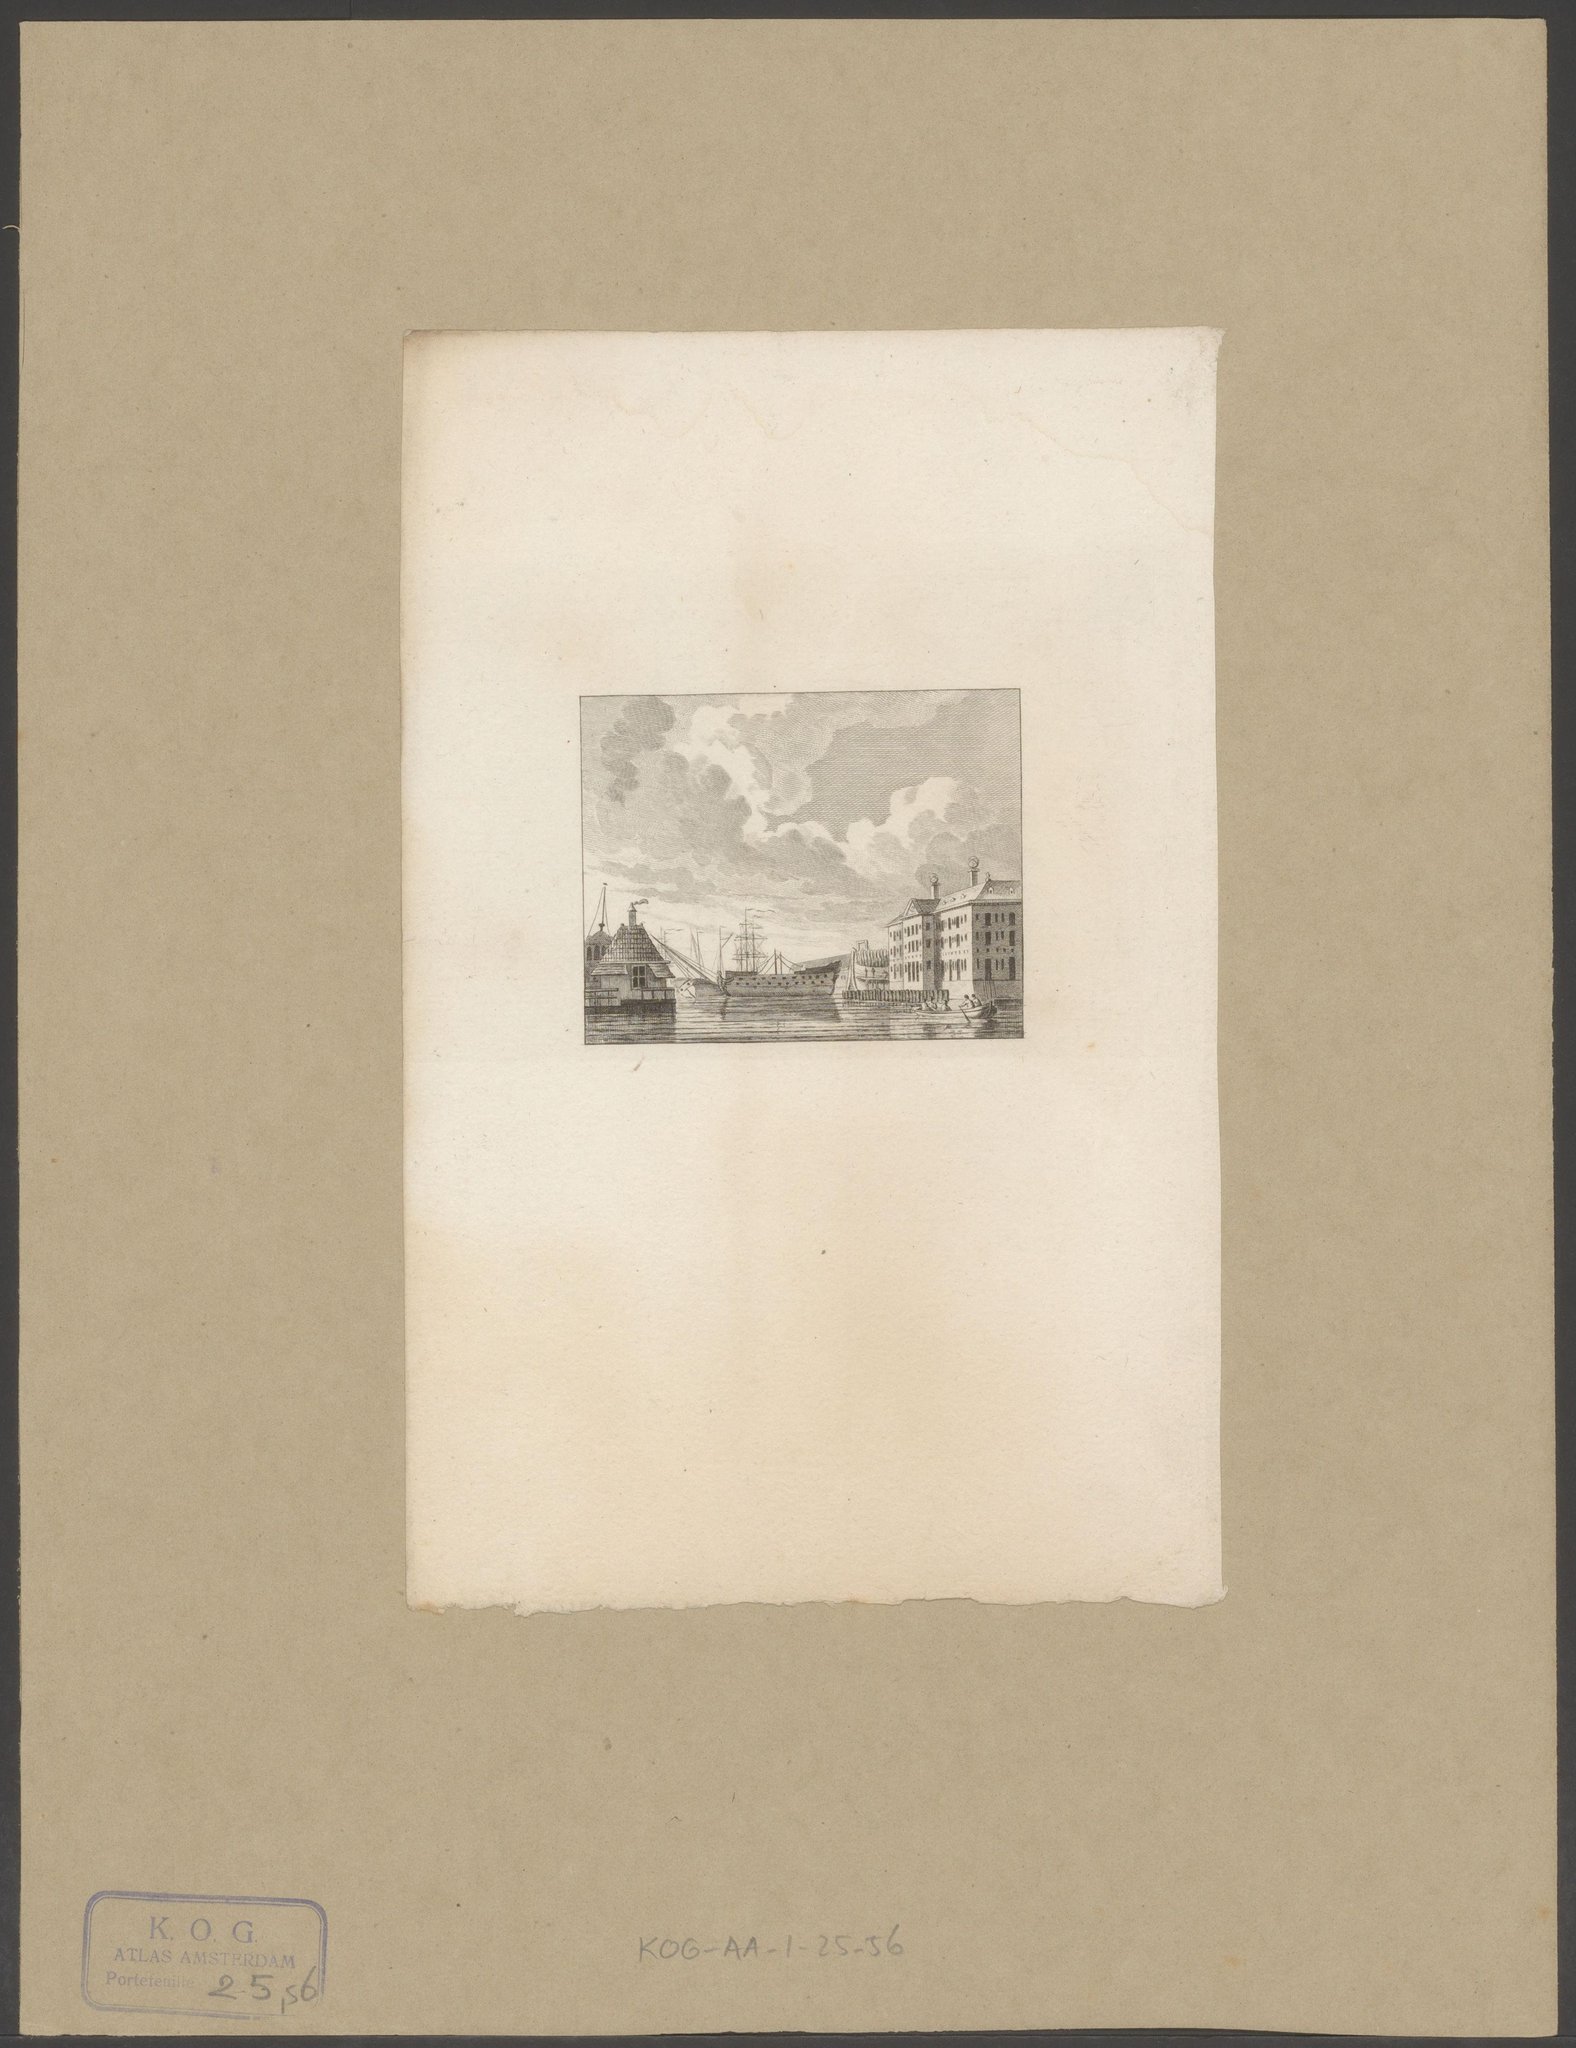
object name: print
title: Stadsgezicht met Admiraliteitswerf te Amsterdam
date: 1770-1790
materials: paper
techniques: etching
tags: large-scale structure for storage, e.g.: warehouse, depot, silo, canals, waters (in city), civic architecture; edifices; dwellings, ammunition store, arsenal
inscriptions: collector's mark: ‘25.56’ Lugt 1641b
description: Onderwerpsrubriek binnen de Atlas Amsterdam: Krijgswezen I: De Admiraliteit van Amsterdam, A. Admiraliteitsgebouwen.